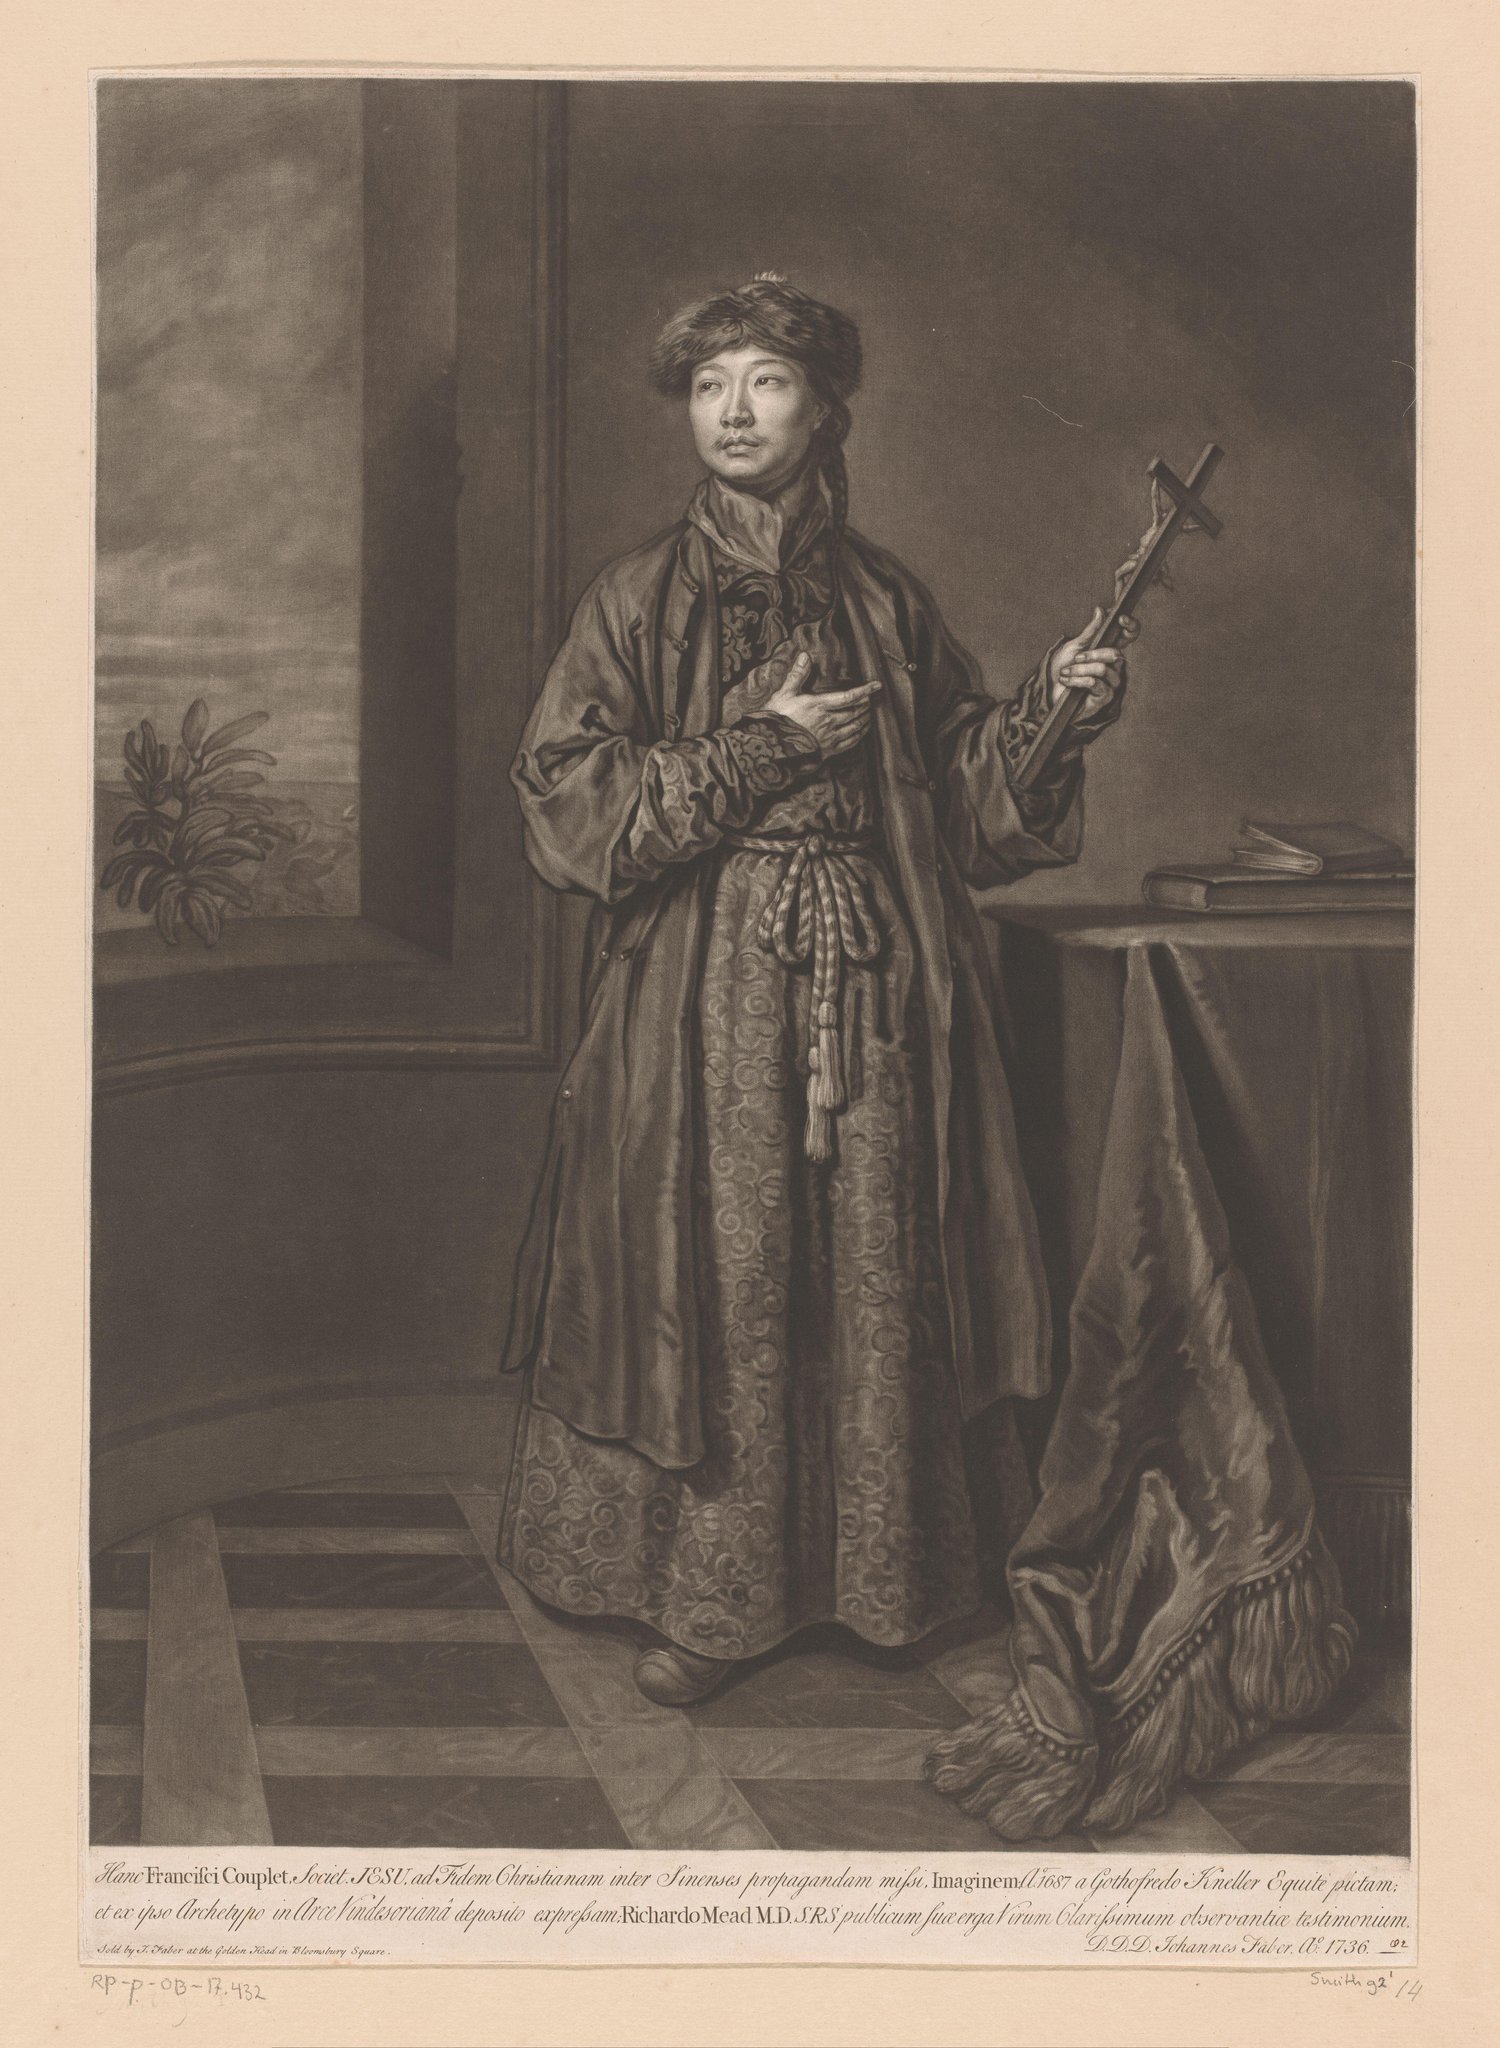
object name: print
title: Portret van Francis Couplet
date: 1736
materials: paper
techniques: etching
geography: london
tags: missionary, historical persons, spreading the gospel; missionary work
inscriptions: collector's mark: Lugt 240